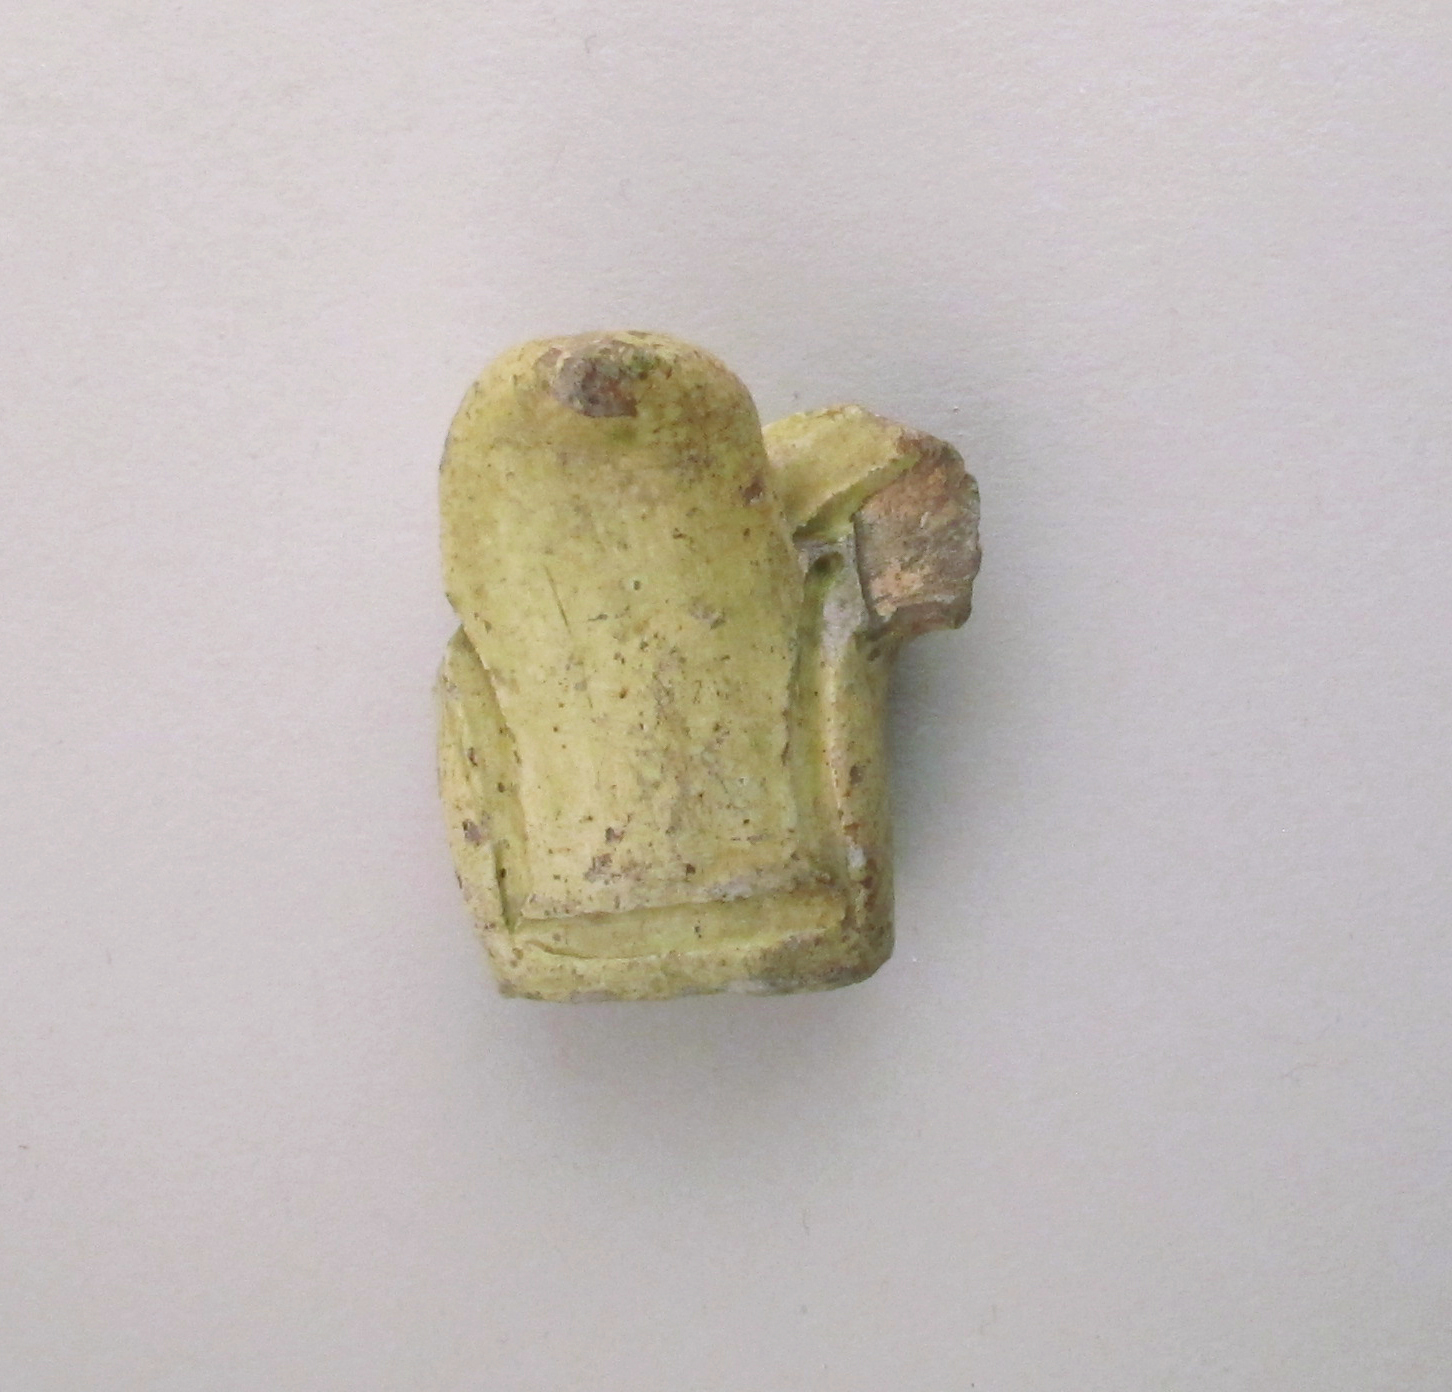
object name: vase fragment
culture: roman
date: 670 BCE-330 CE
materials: terracotta